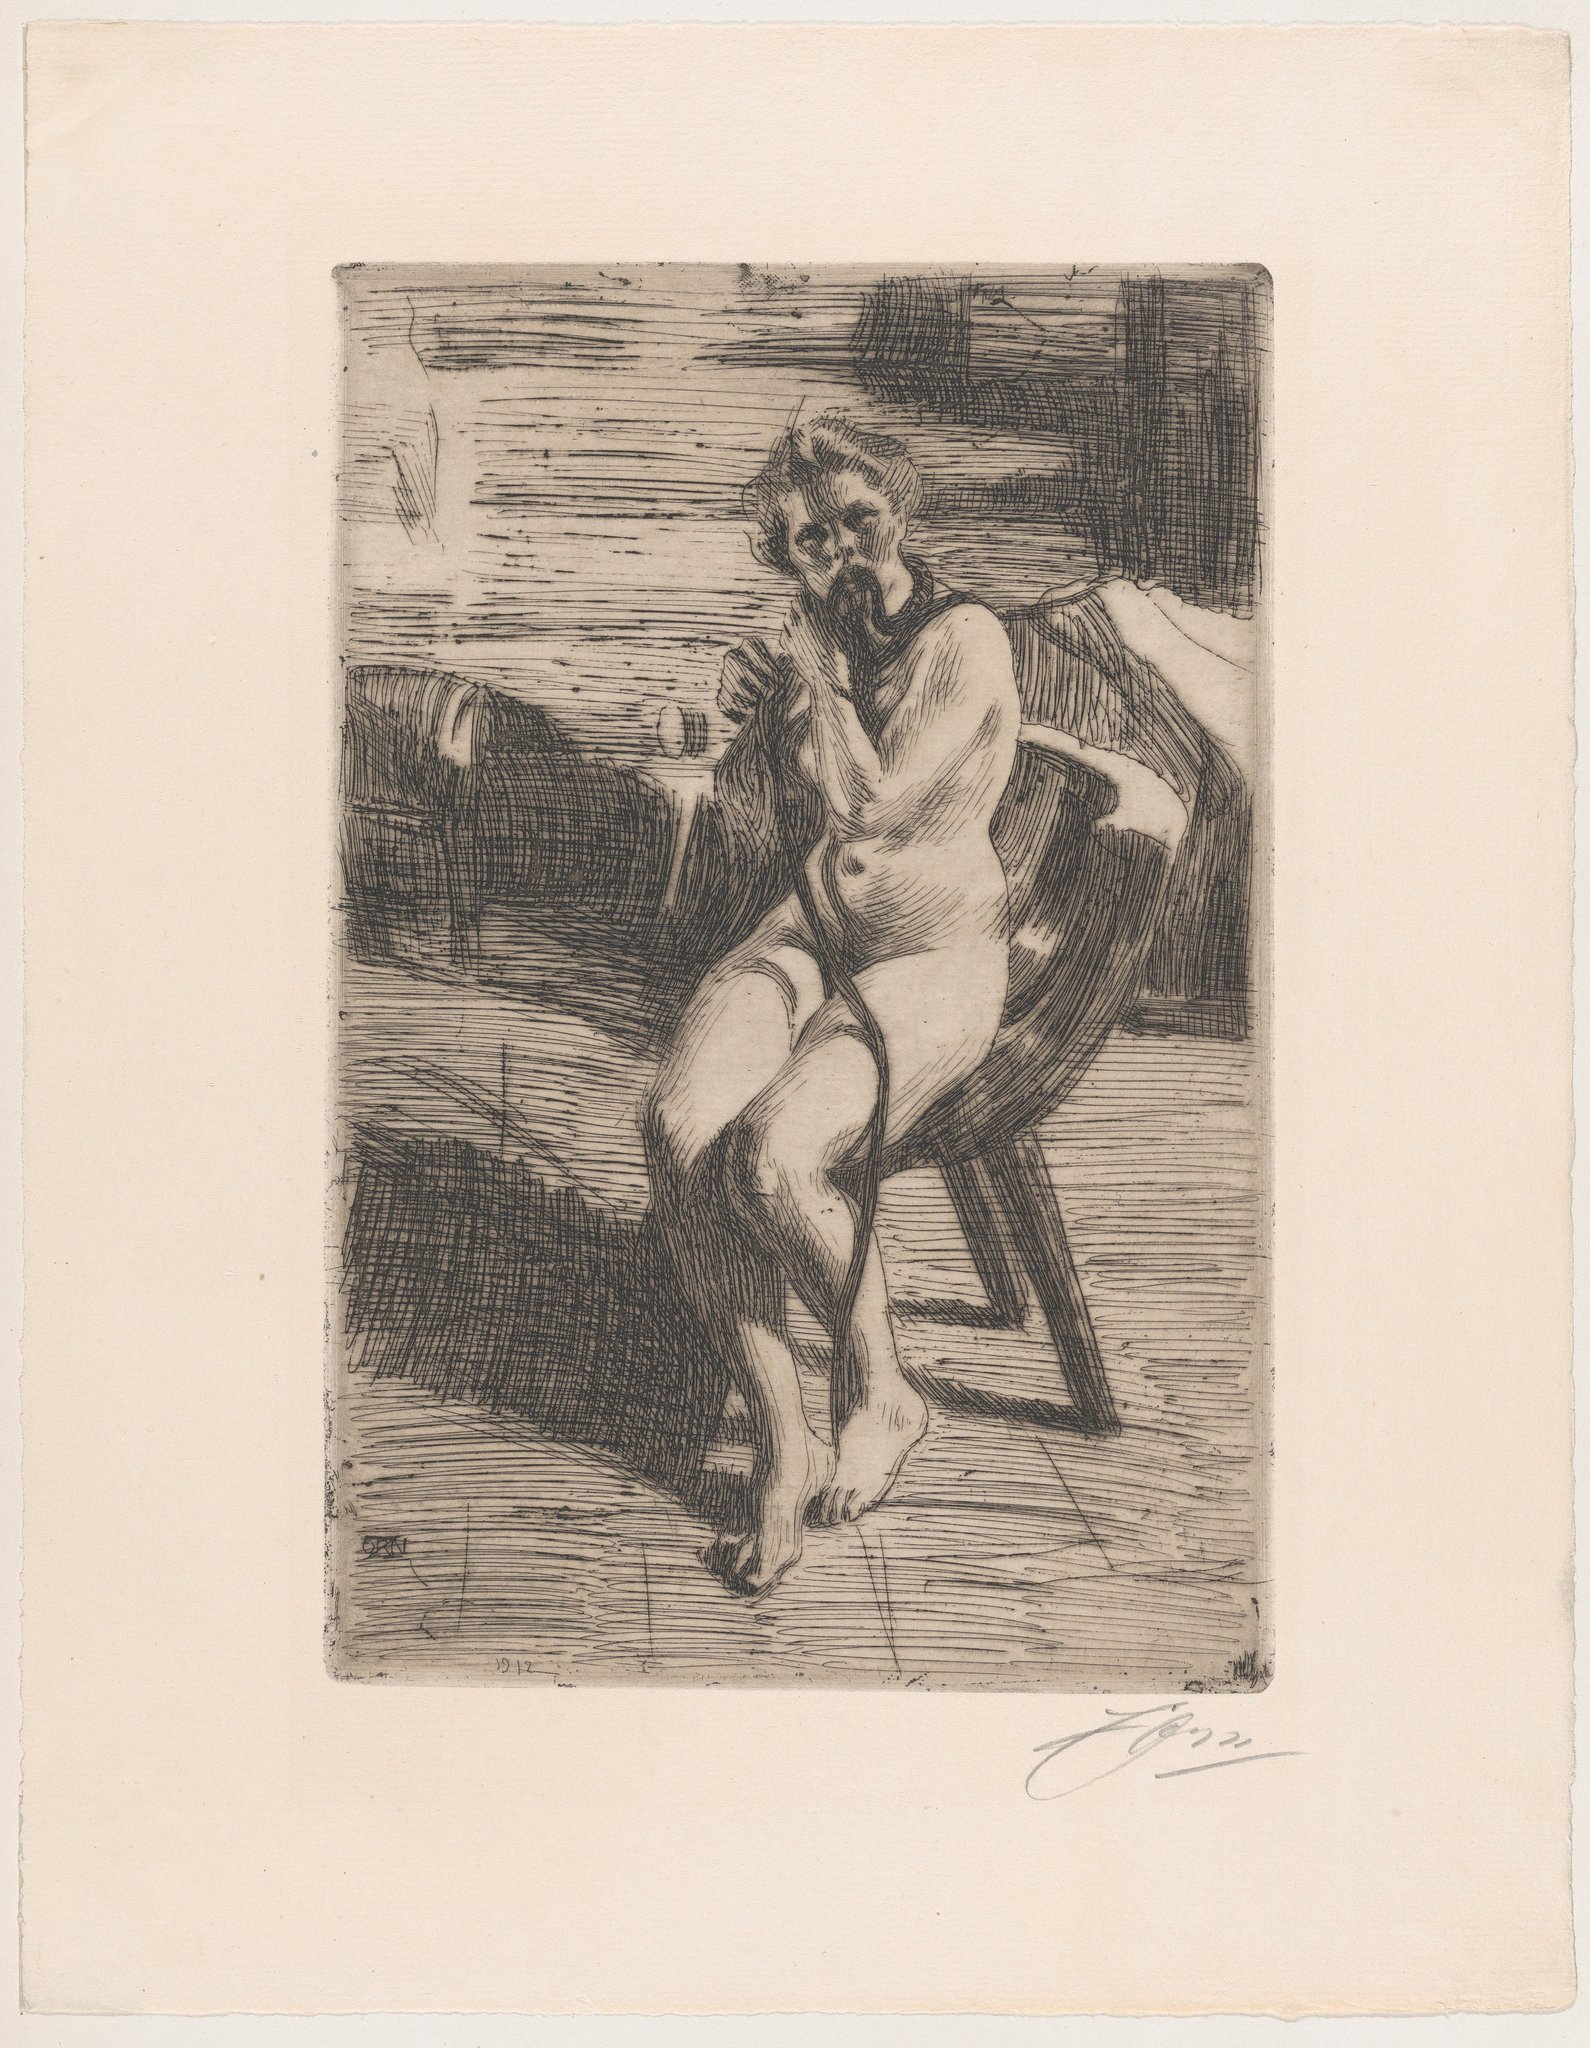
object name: print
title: The Hair-Ribbon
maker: anders zorn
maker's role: artist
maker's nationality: swedish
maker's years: 1860-1920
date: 1912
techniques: etching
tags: male nudes